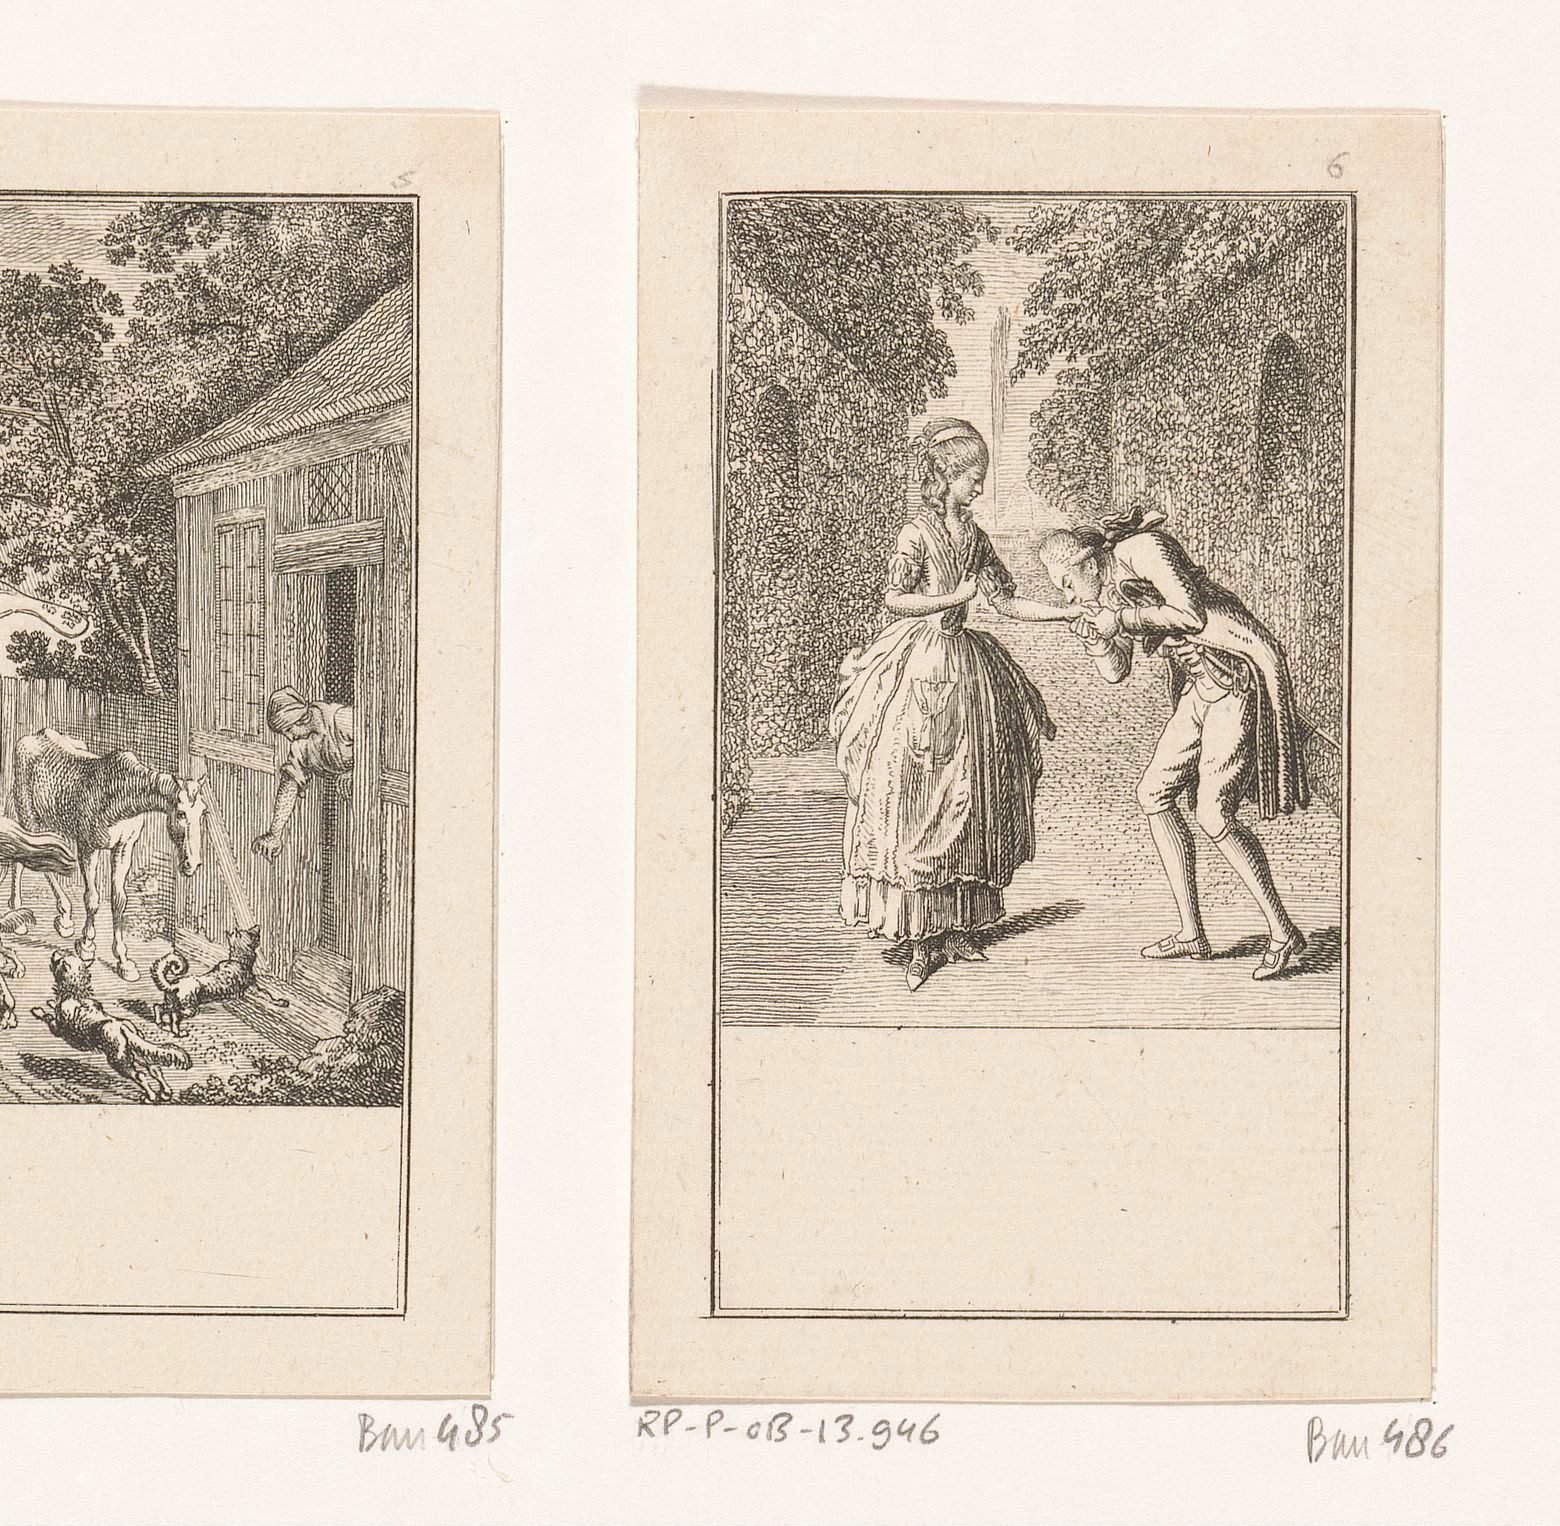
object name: print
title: Man geeft een vrouw een handkus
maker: daniel nikolaus chodowiecki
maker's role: draughtsman, print maker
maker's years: 1726-1801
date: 1778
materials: paper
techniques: etching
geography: berlin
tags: kissing the hand (lovers)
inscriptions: collector's mark: Lugt 2228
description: Zesde prent uit een serie van twaalf moralistische en satirische voorstellingen. De scènes werden op een plaat geëtst. Een latere staat van deze serie is gebruikt in: Launburger genealogischen Kalender auf das Jahr 1779. Deze serie is een herhaling van een eerdere serie met onderschriften in het Duits (zie: RP-P-OB-13.938) en het Frans (zie: RP-P-OB-13.393 en RP-P-OB-13.940).